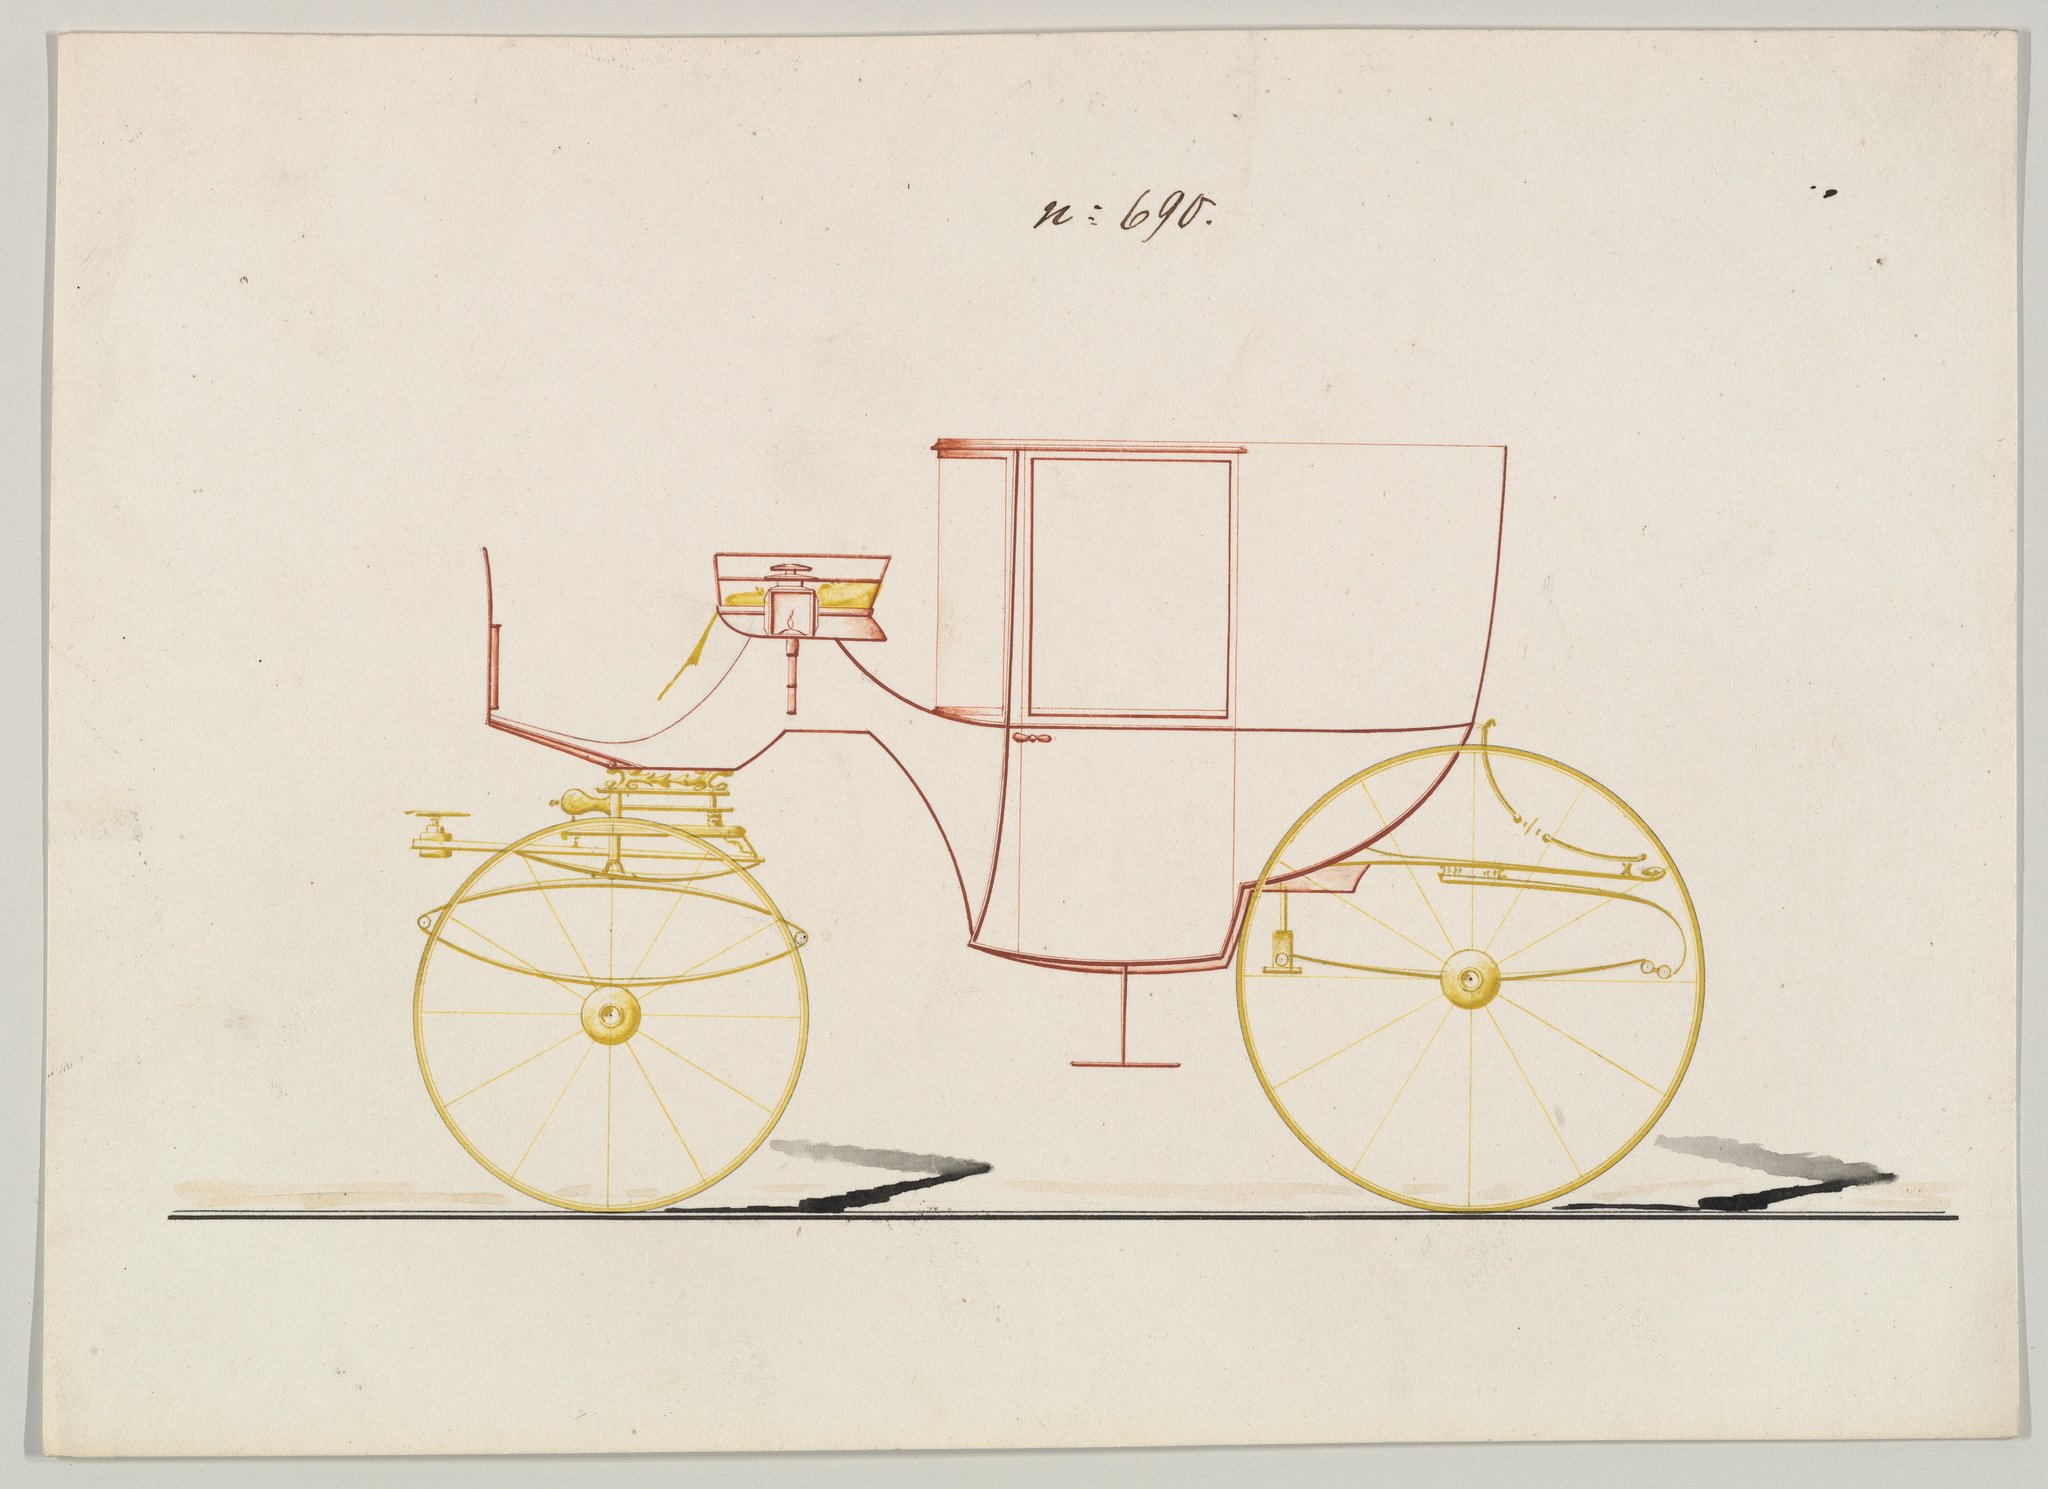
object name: drawing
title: Design for Coupé, no. 690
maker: brewster & co.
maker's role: manufacturer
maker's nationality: american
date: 1850-1870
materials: watercolor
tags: carriages